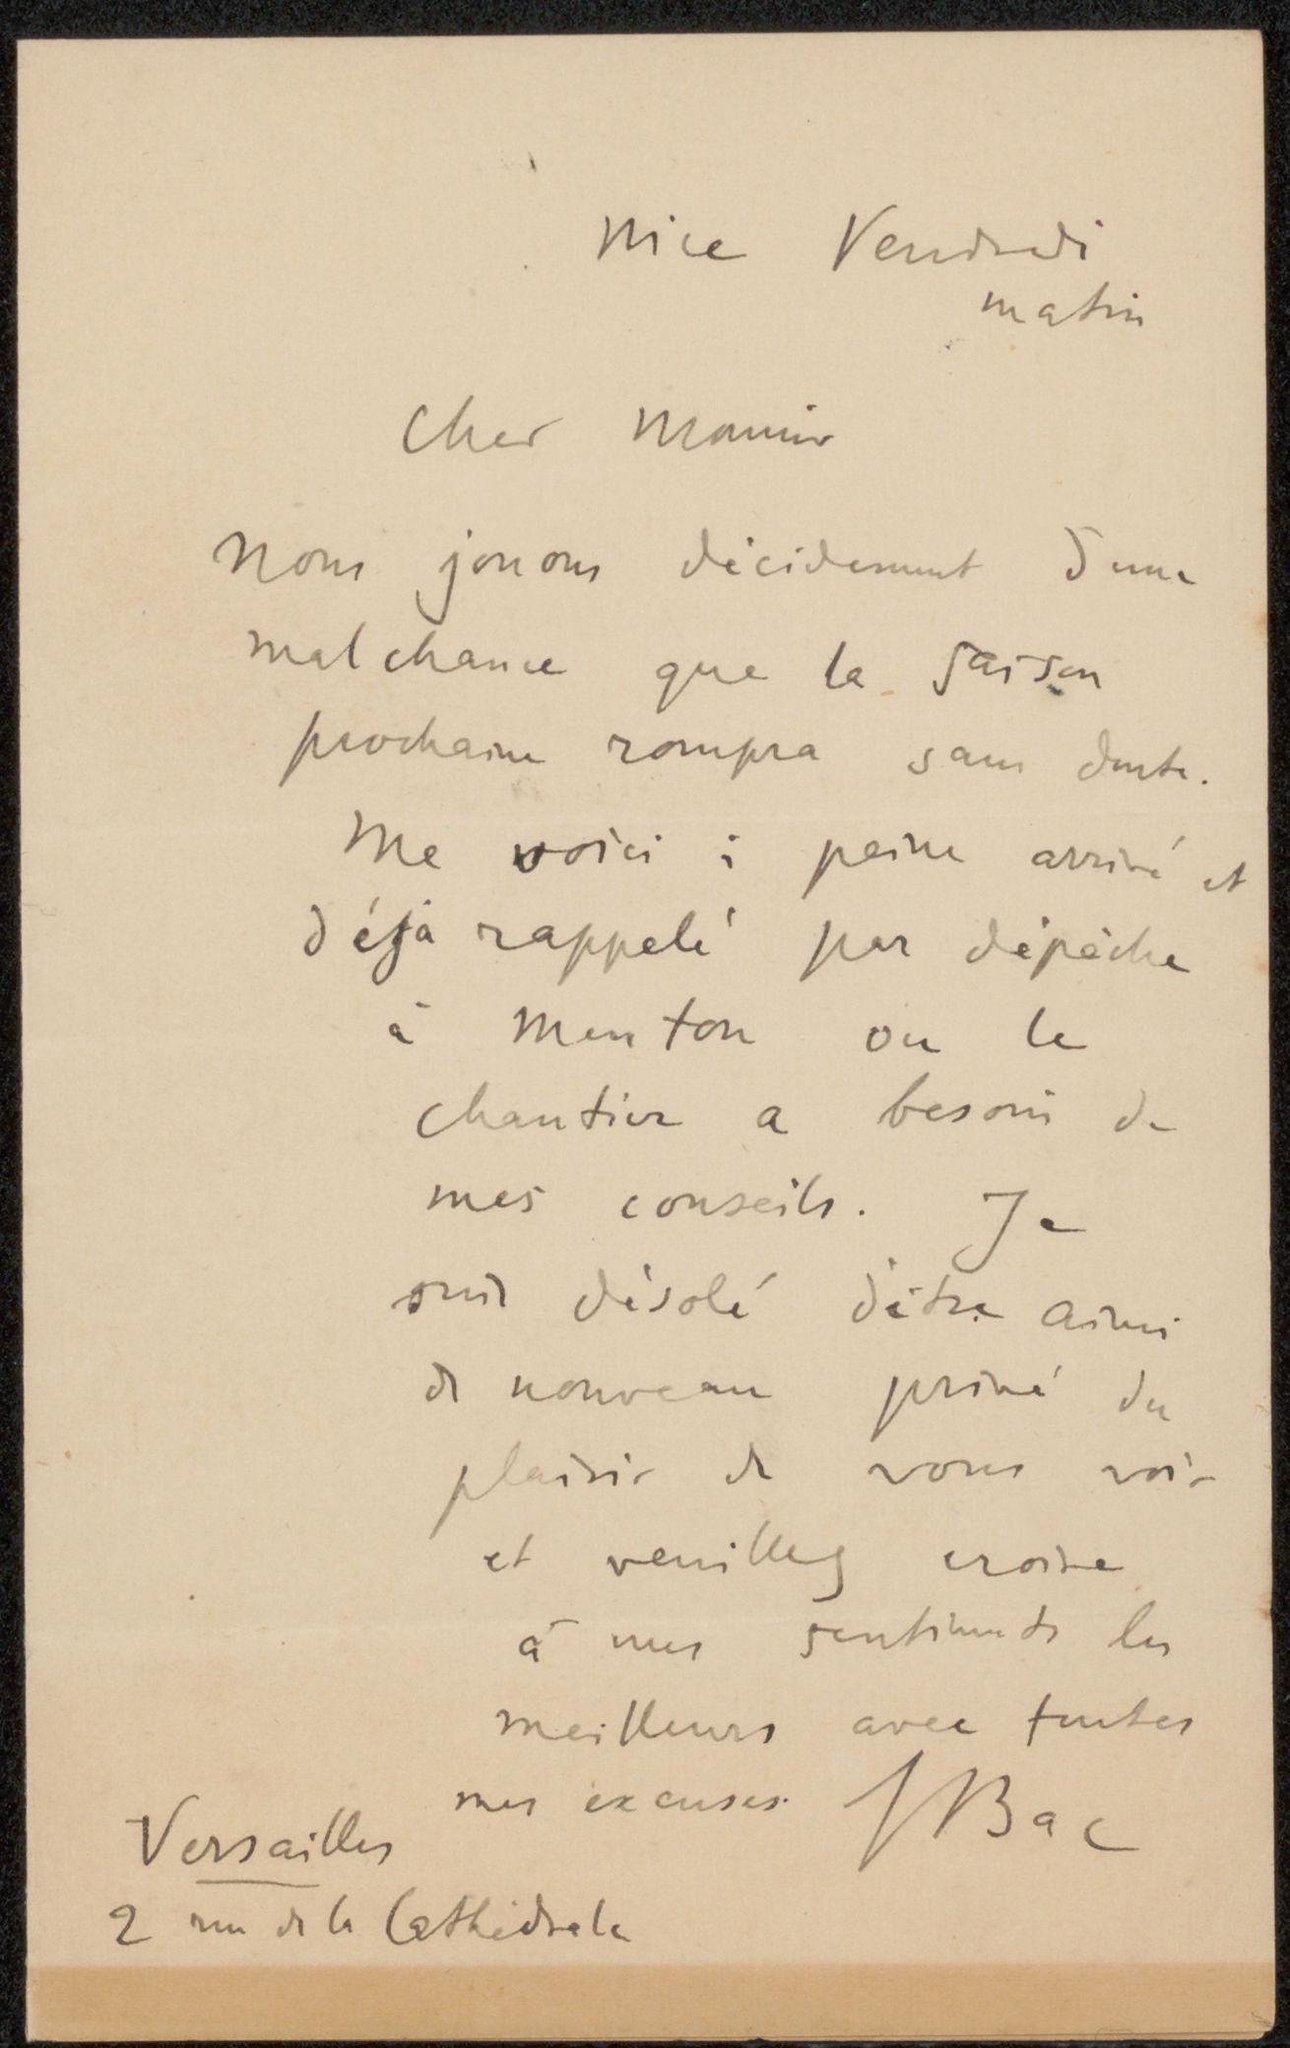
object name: letter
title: Brief aan Philip Zilcken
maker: ferdinand-sigismund bac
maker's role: draughtsman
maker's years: 1859-1952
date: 1869-1952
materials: ink, paper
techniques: pen, writing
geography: nice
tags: the hague, painter, draughtsman, philip zilcken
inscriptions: collector's mark: ‘RPK’